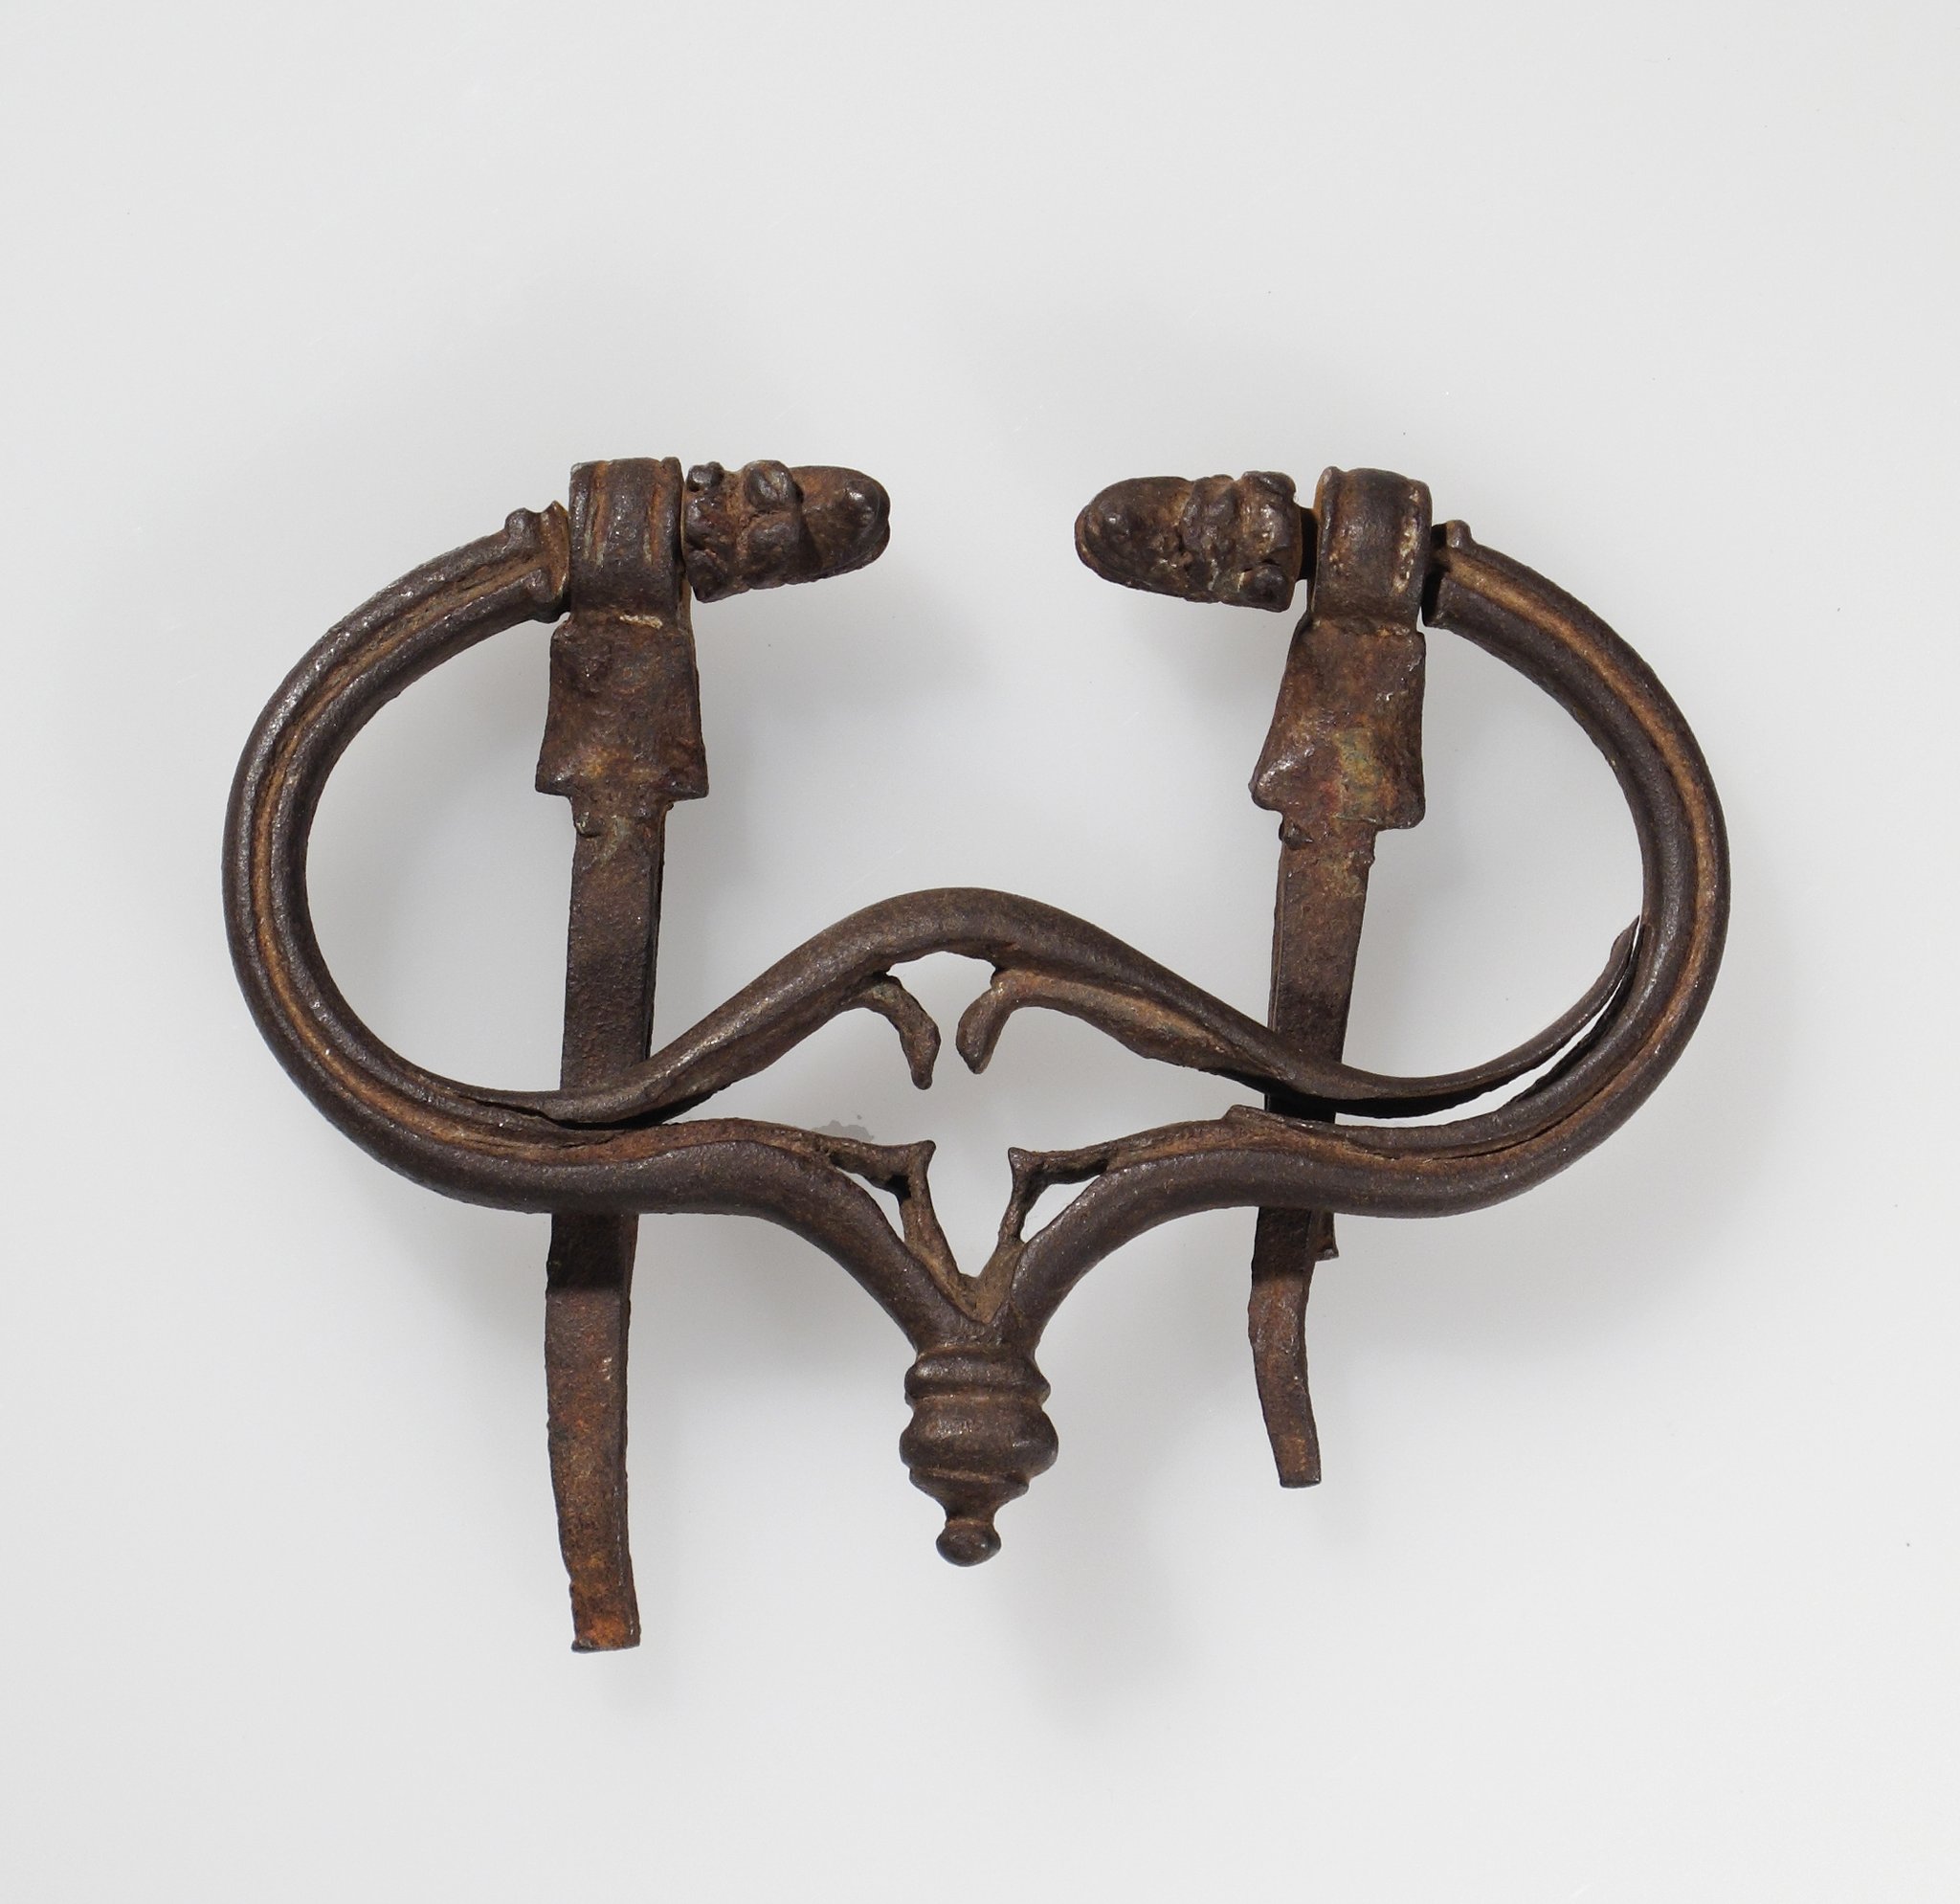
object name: door knocker ring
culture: european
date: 1401-1600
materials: iron